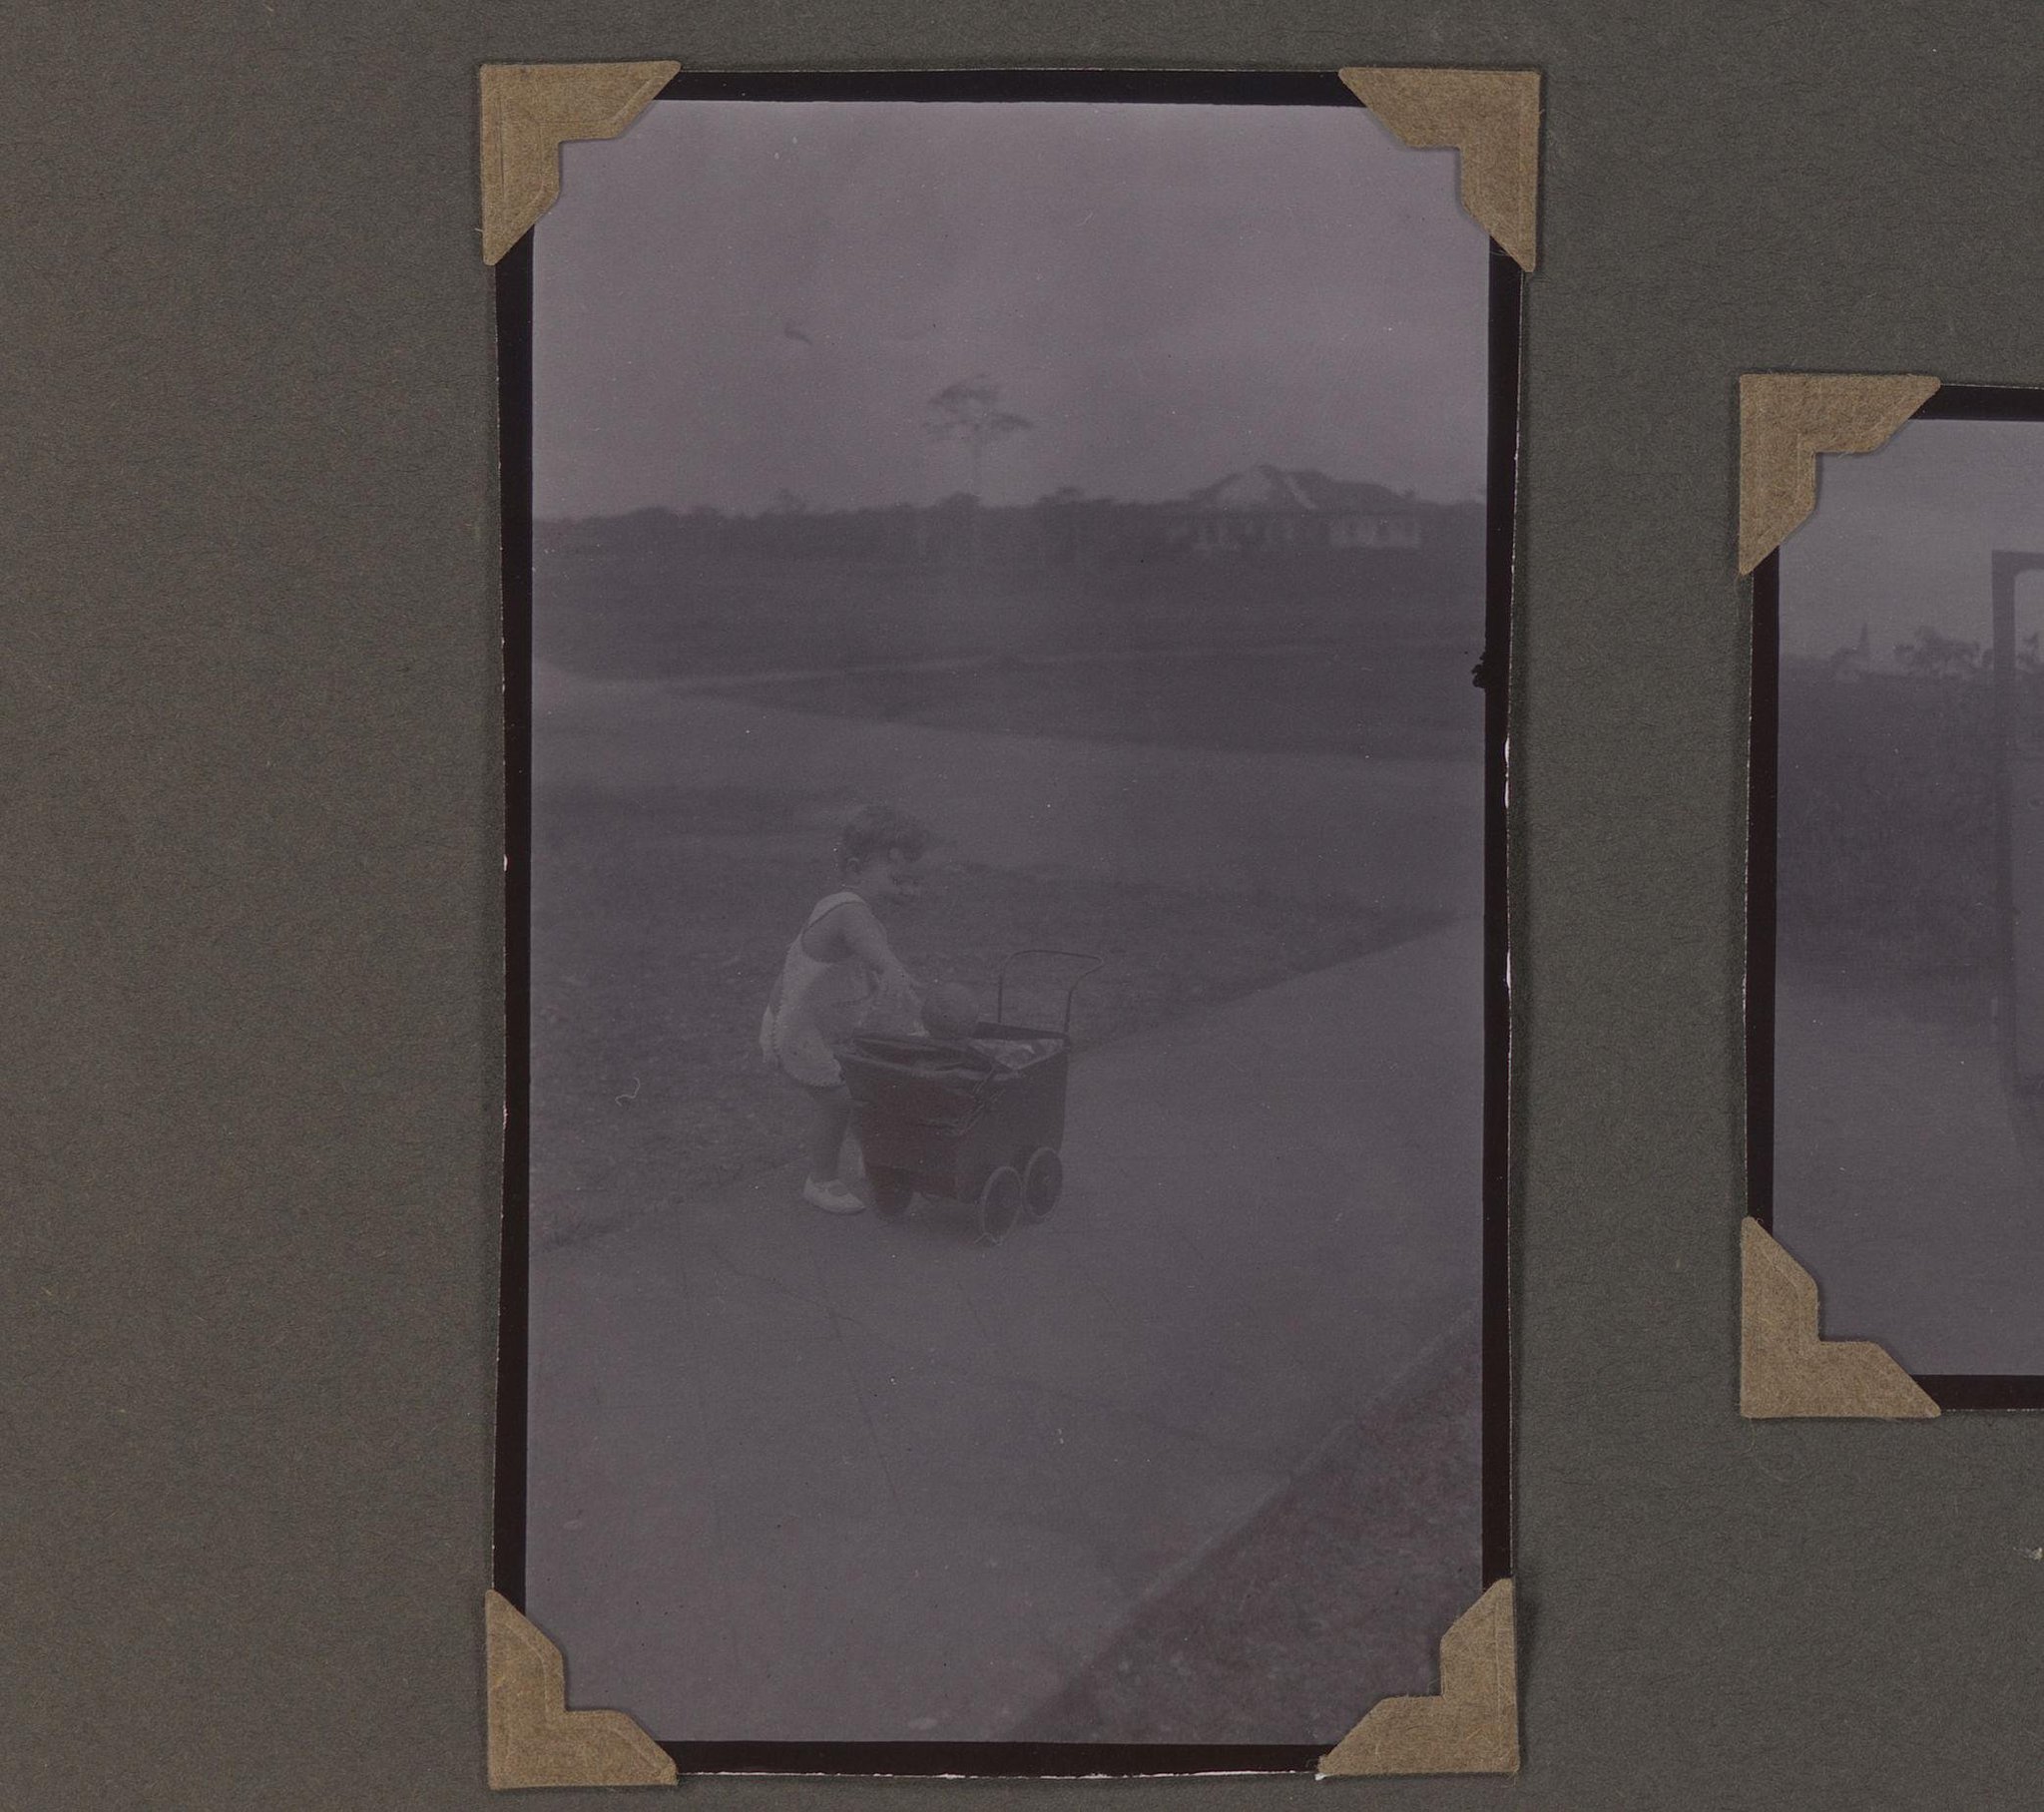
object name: photograph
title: Familiefoto van het gezin Jetten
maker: Anonymous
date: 1925-1927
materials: photographic support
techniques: photography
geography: suriname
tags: jetten, familie, moengo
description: Familiefoto van de kinderen Jetten in Suriname. Foto op een bladzijde van een los albumblad. Onderdeel van het ensemble met foto's van de familie van ingenieur Jetten in de mijnbouwstad Moengo in Suriname.